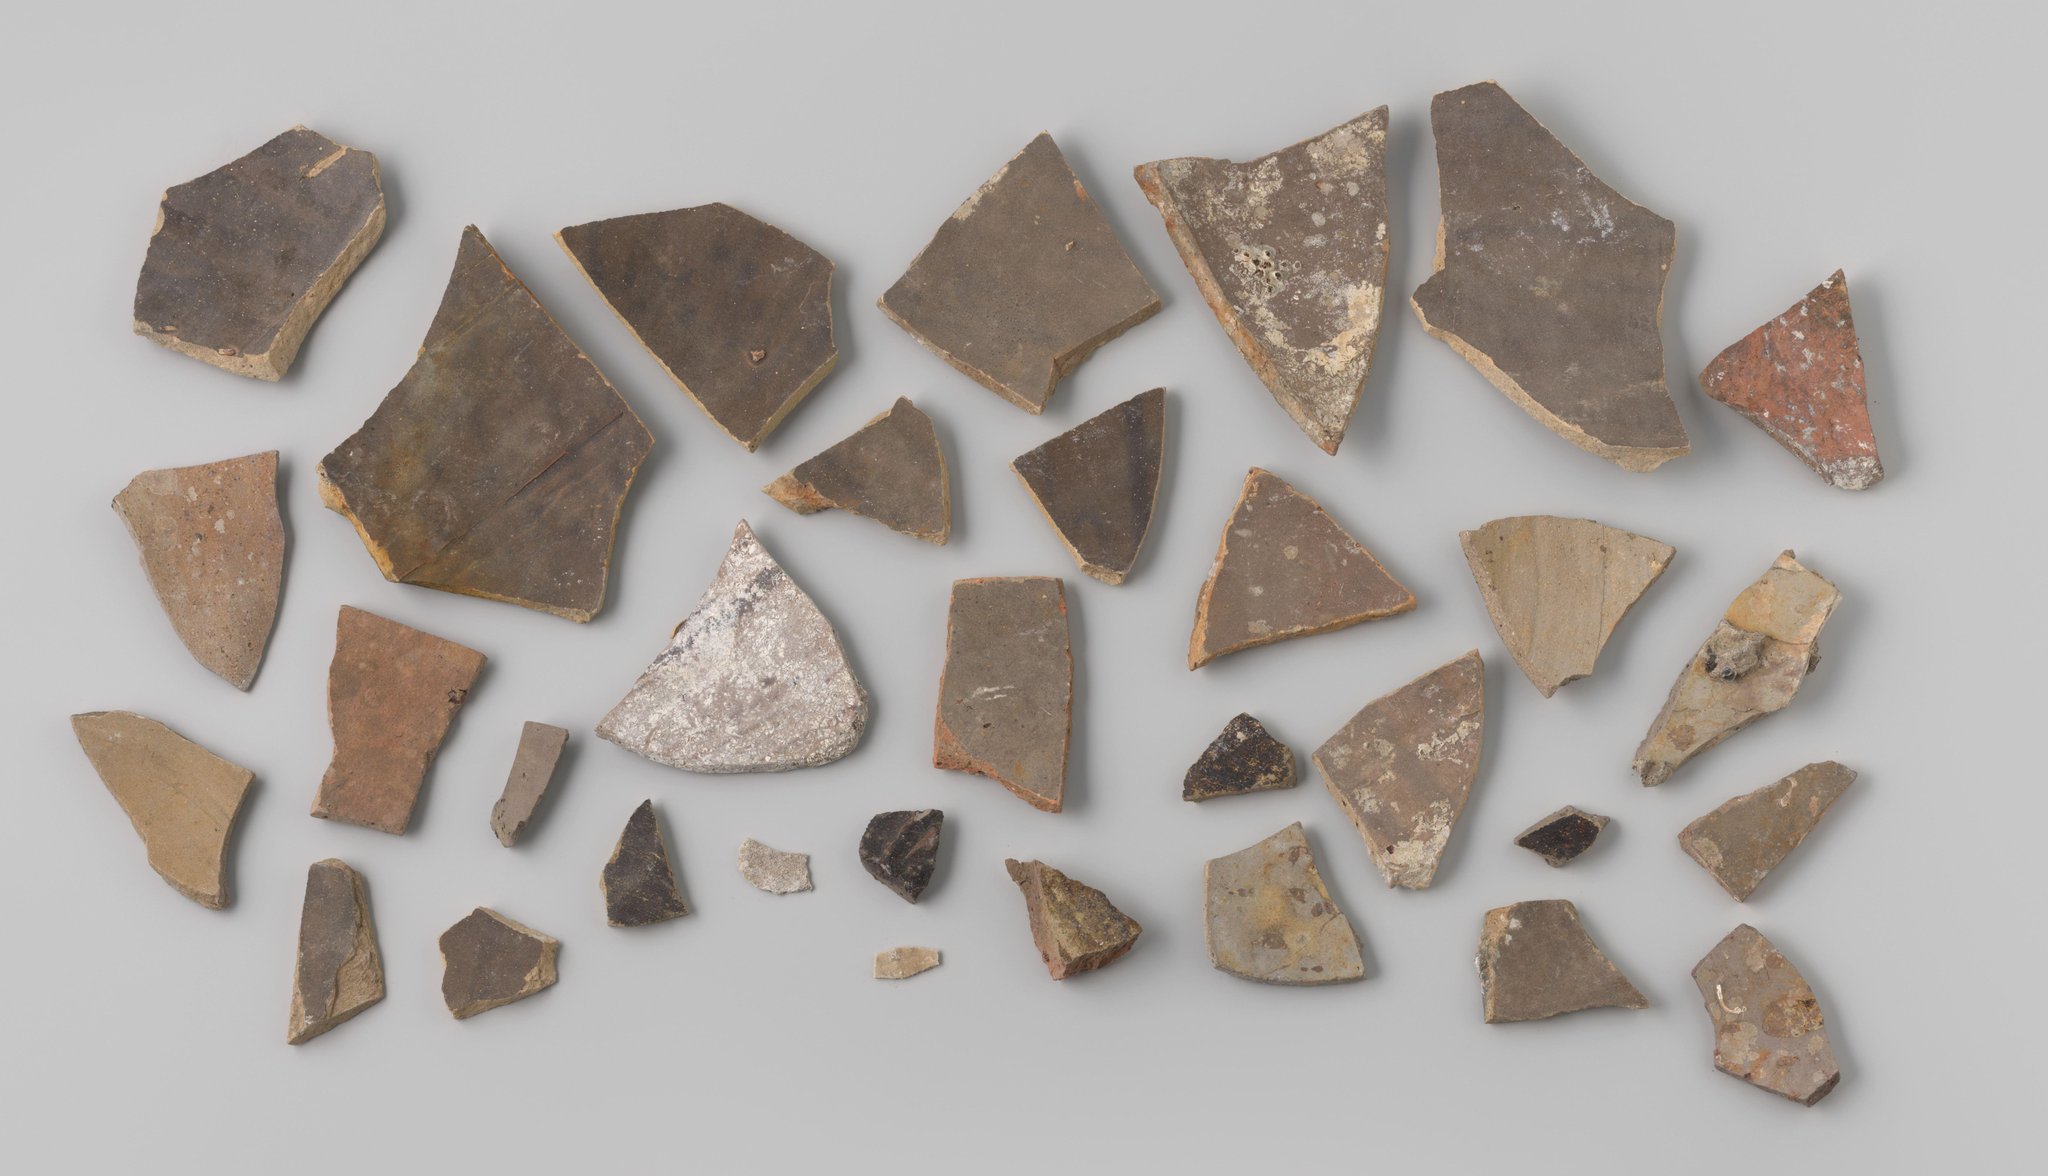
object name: martavaan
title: Scherven uit V.O.C.-schip de 'Witte Leeuw'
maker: Anonymous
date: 1613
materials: porcelain, stoneware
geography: southeast asia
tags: verenigde oostindische compagnie, sint-helena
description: Scherven uit V.O.C.-schip de 'Witte Leeuw'.